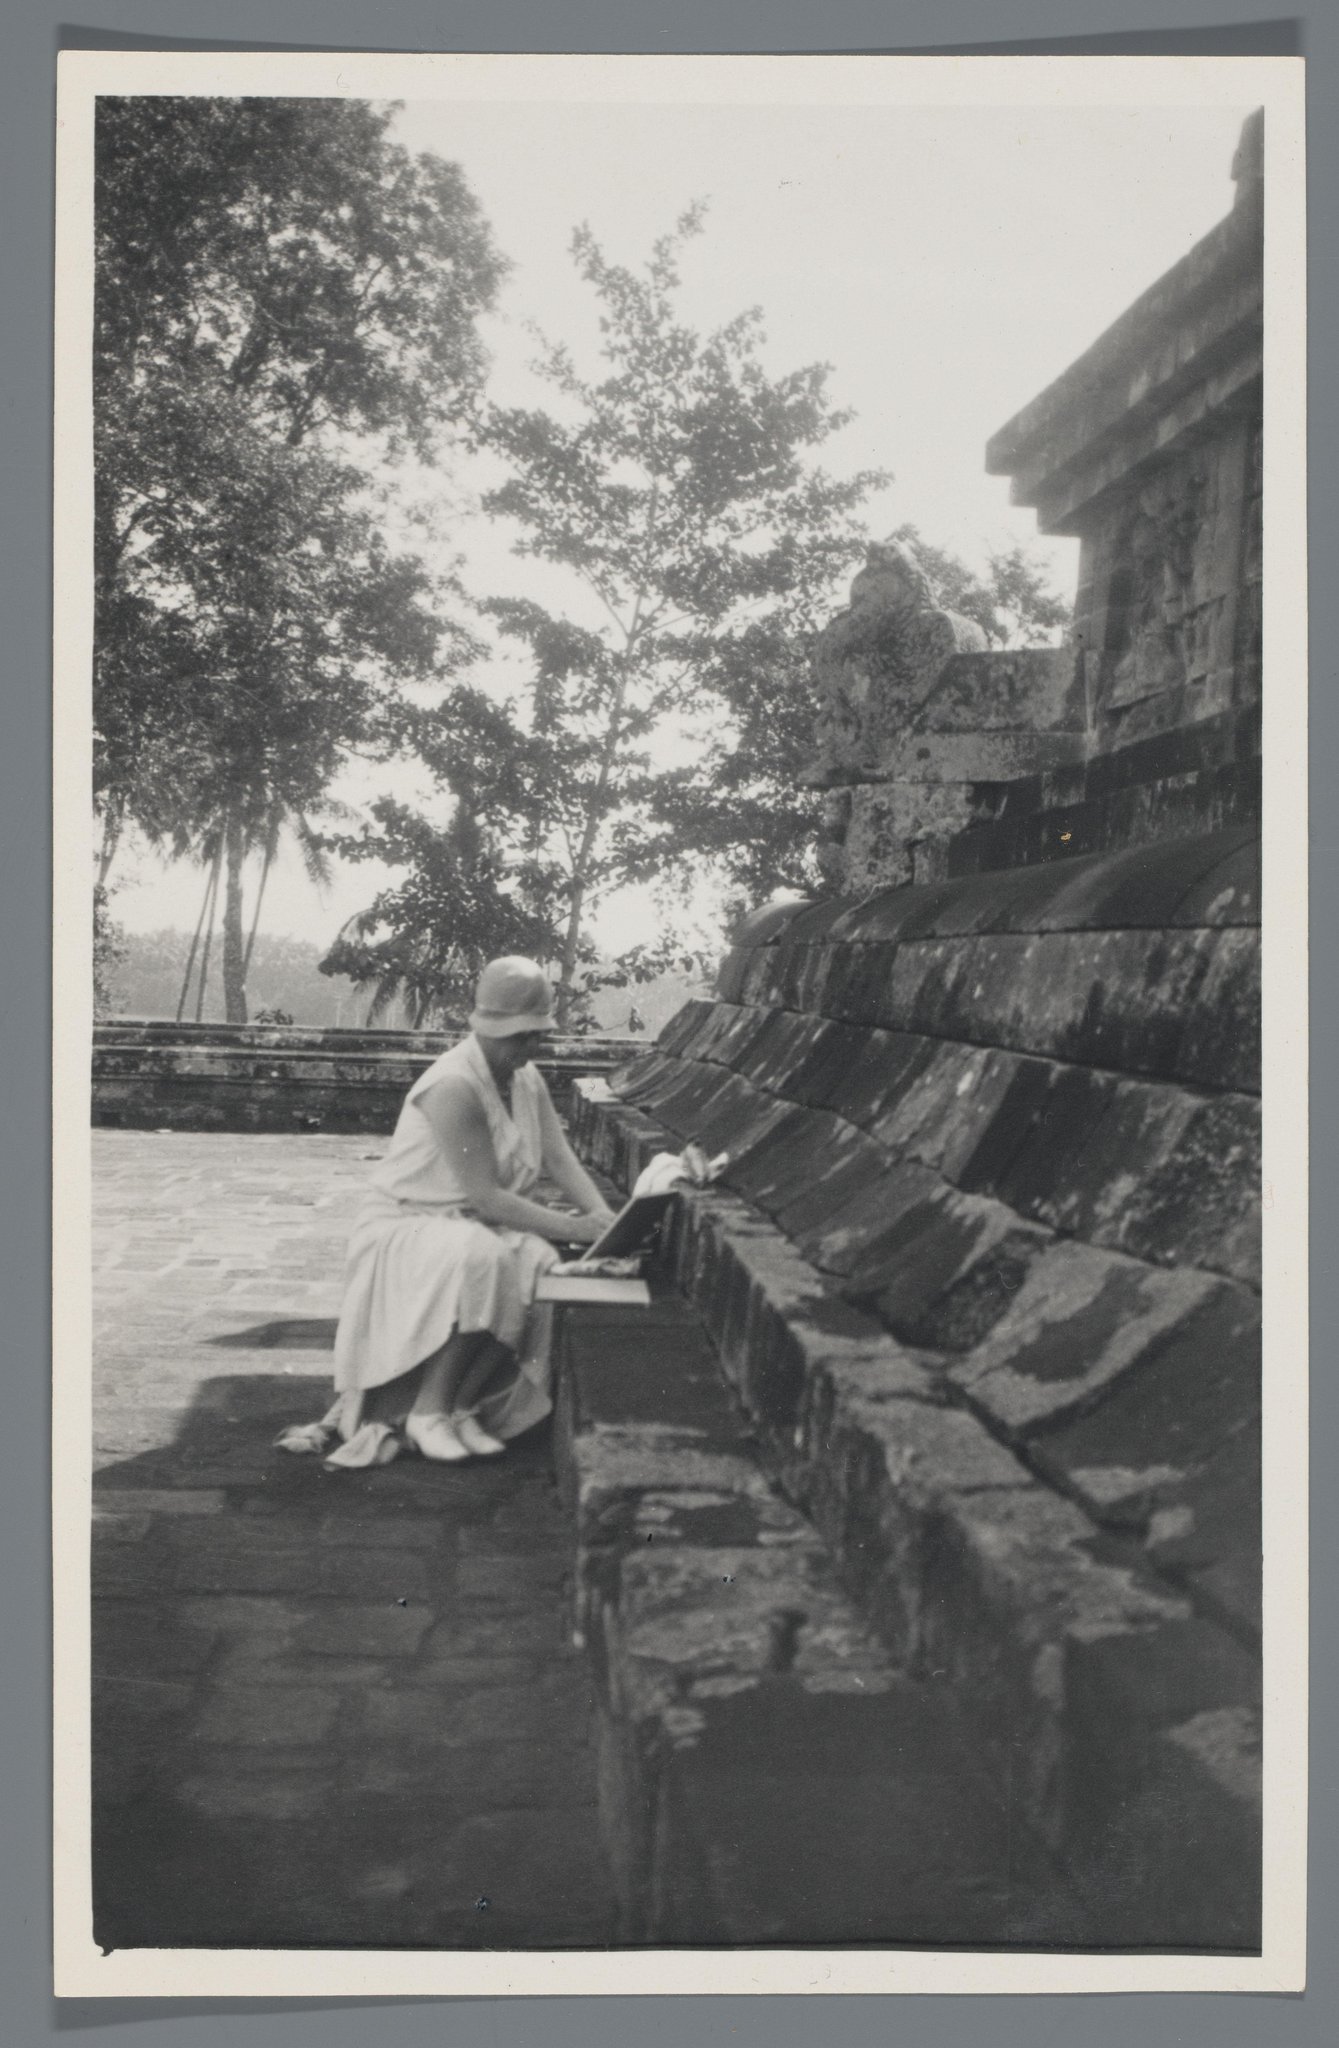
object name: photograph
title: Foto behorende bij het fotoalbum Reis door Azië van H.K. Westendorp en B. Osieck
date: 1930-1931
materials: photographic support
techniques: gelatin silver print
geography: asia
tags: azië